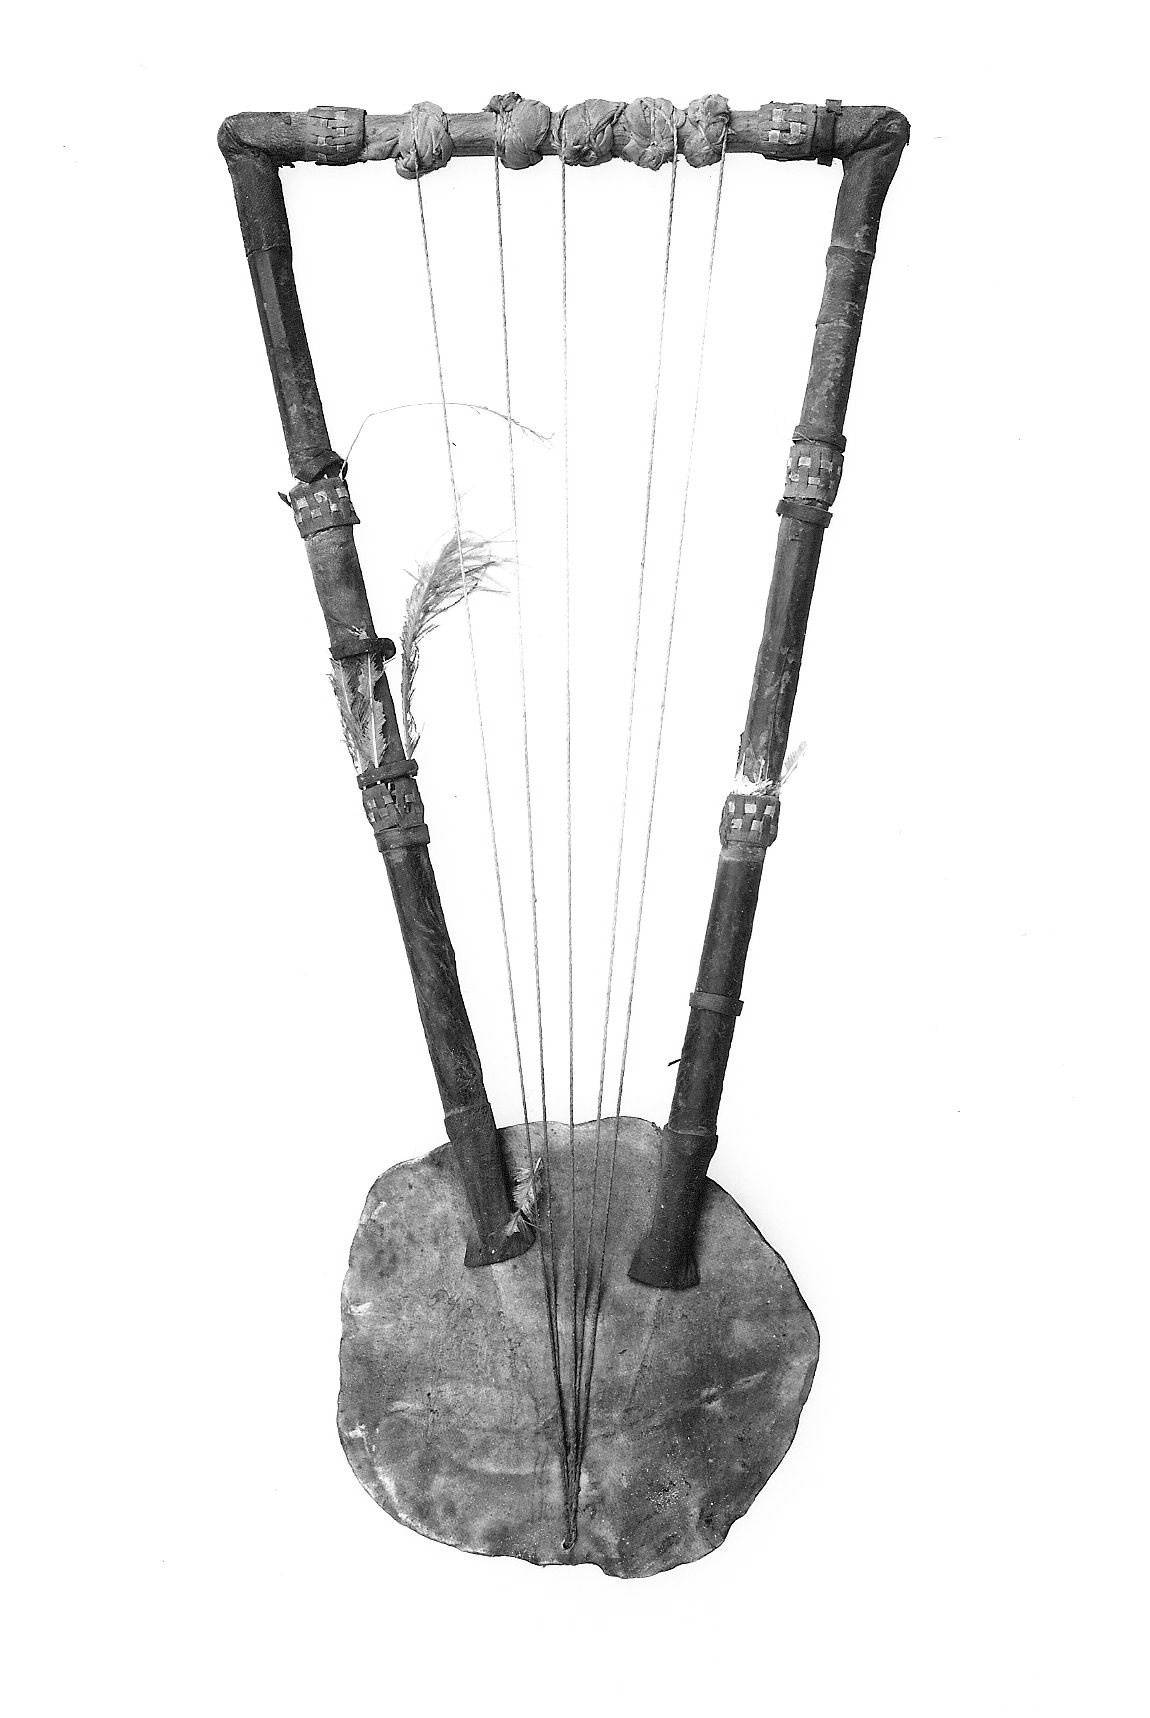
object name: kissar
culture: east african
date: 1867-1900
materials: feather, leather, shell, wood